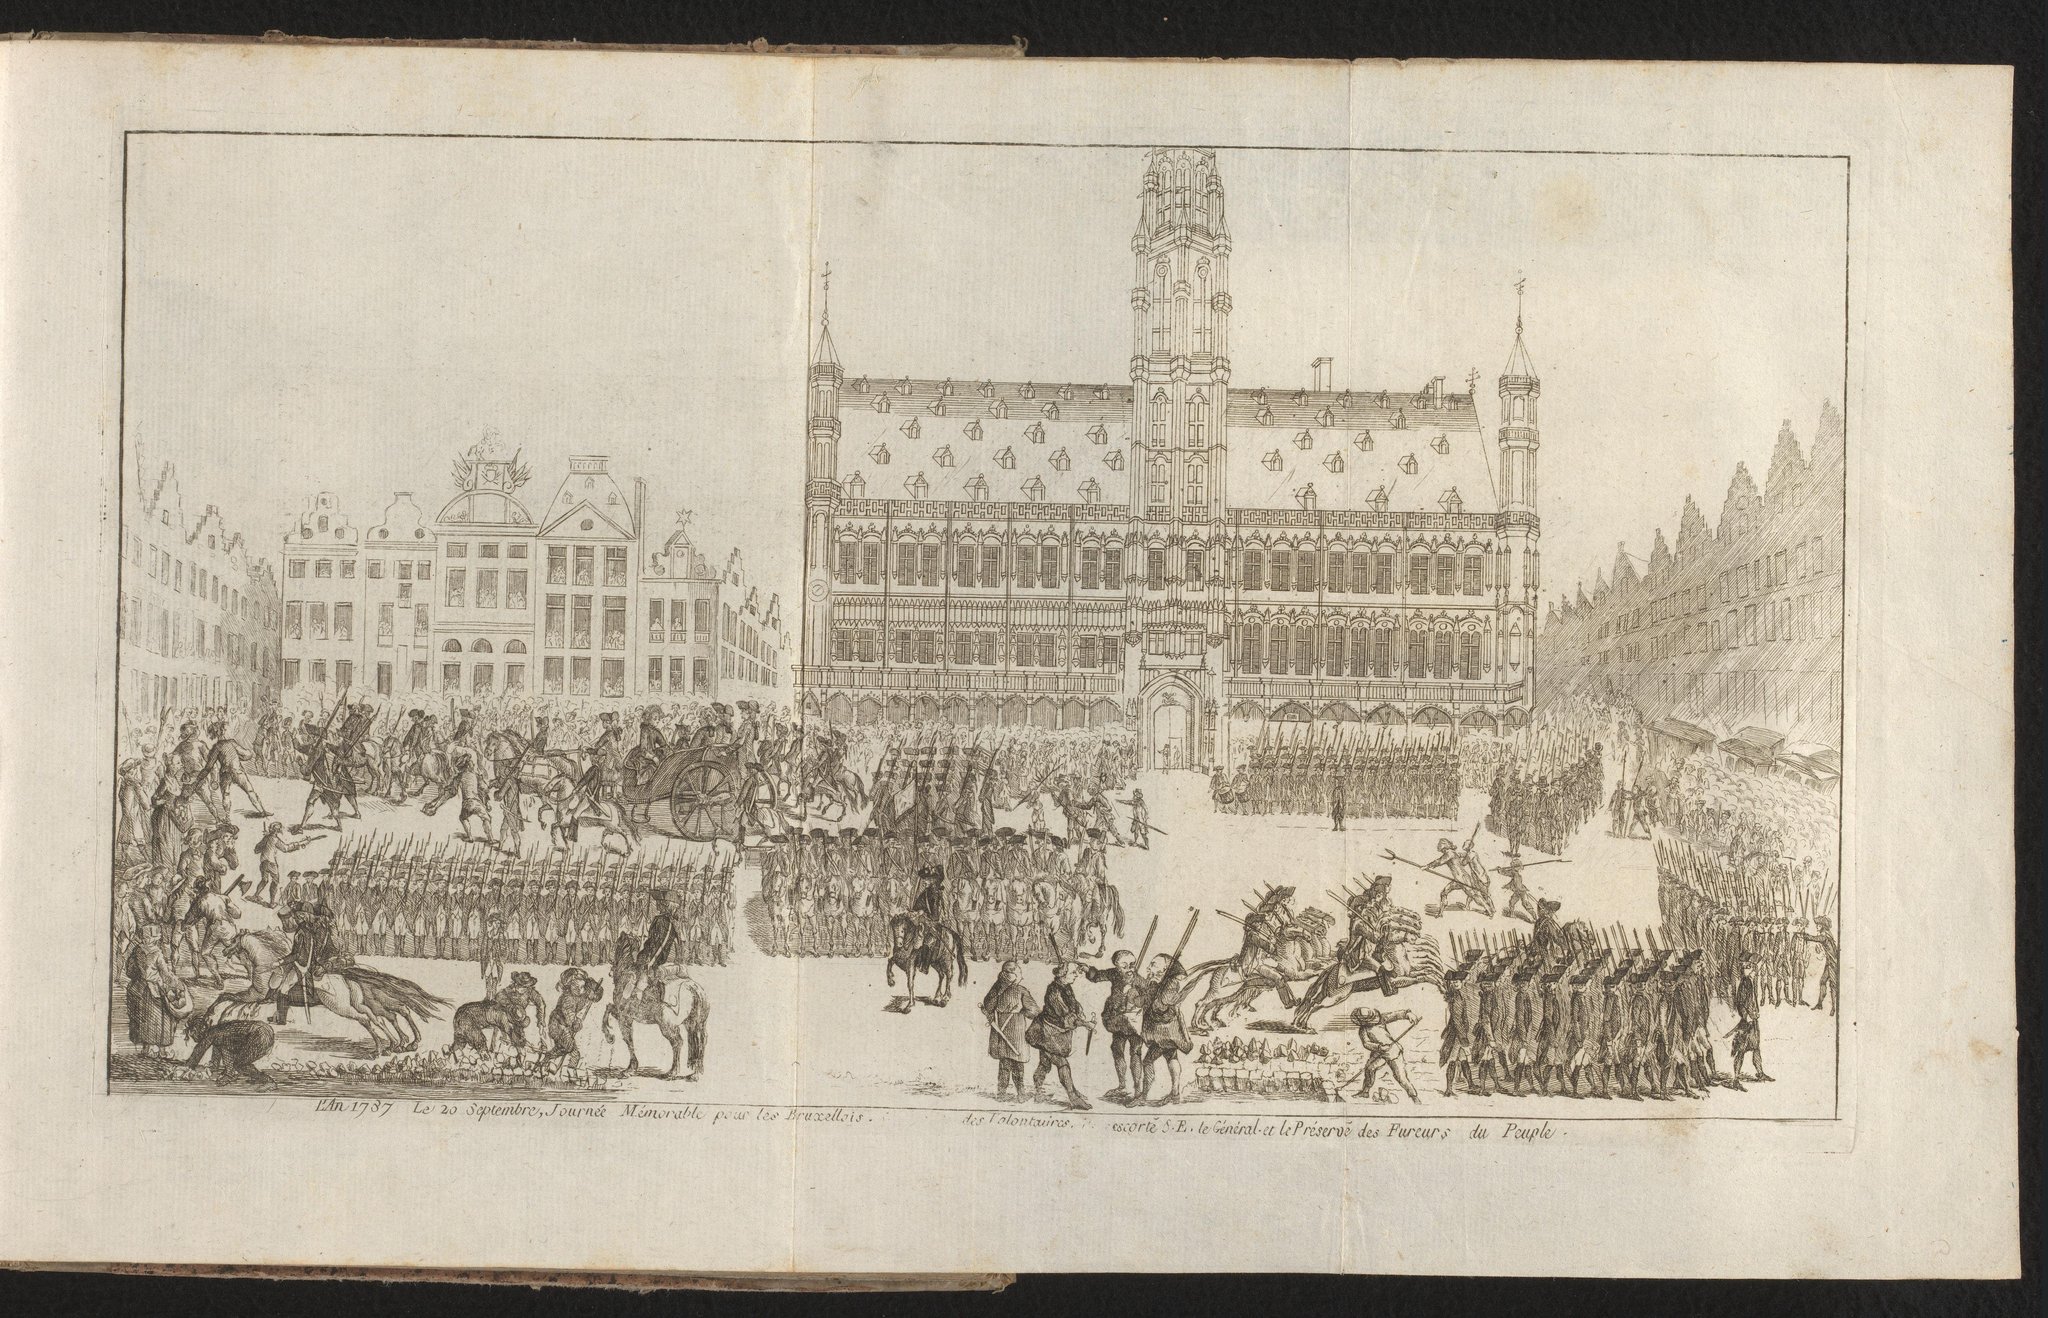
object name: print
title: Generaal d'Alton geëscorteerd door de vrijwilligers te Brussel, 1787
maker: Anonymous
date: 1787-1790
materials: paper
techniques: engraving, etching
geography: southern netherlands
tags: revolution, revolt, brabant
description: Het rijtuig met de Oostenrijkse generaal d'Alton geëscorteerd door de Brabantse vrijwilligers tegen het woedende volk op de Grote Markt te Brussel, 20 september 1787. Onderdeel van de gebundelde verzameling prenten betrekking hebbend op de gebeurtenissen van de Brabantse Omwenteling en de periode 1787-1790.